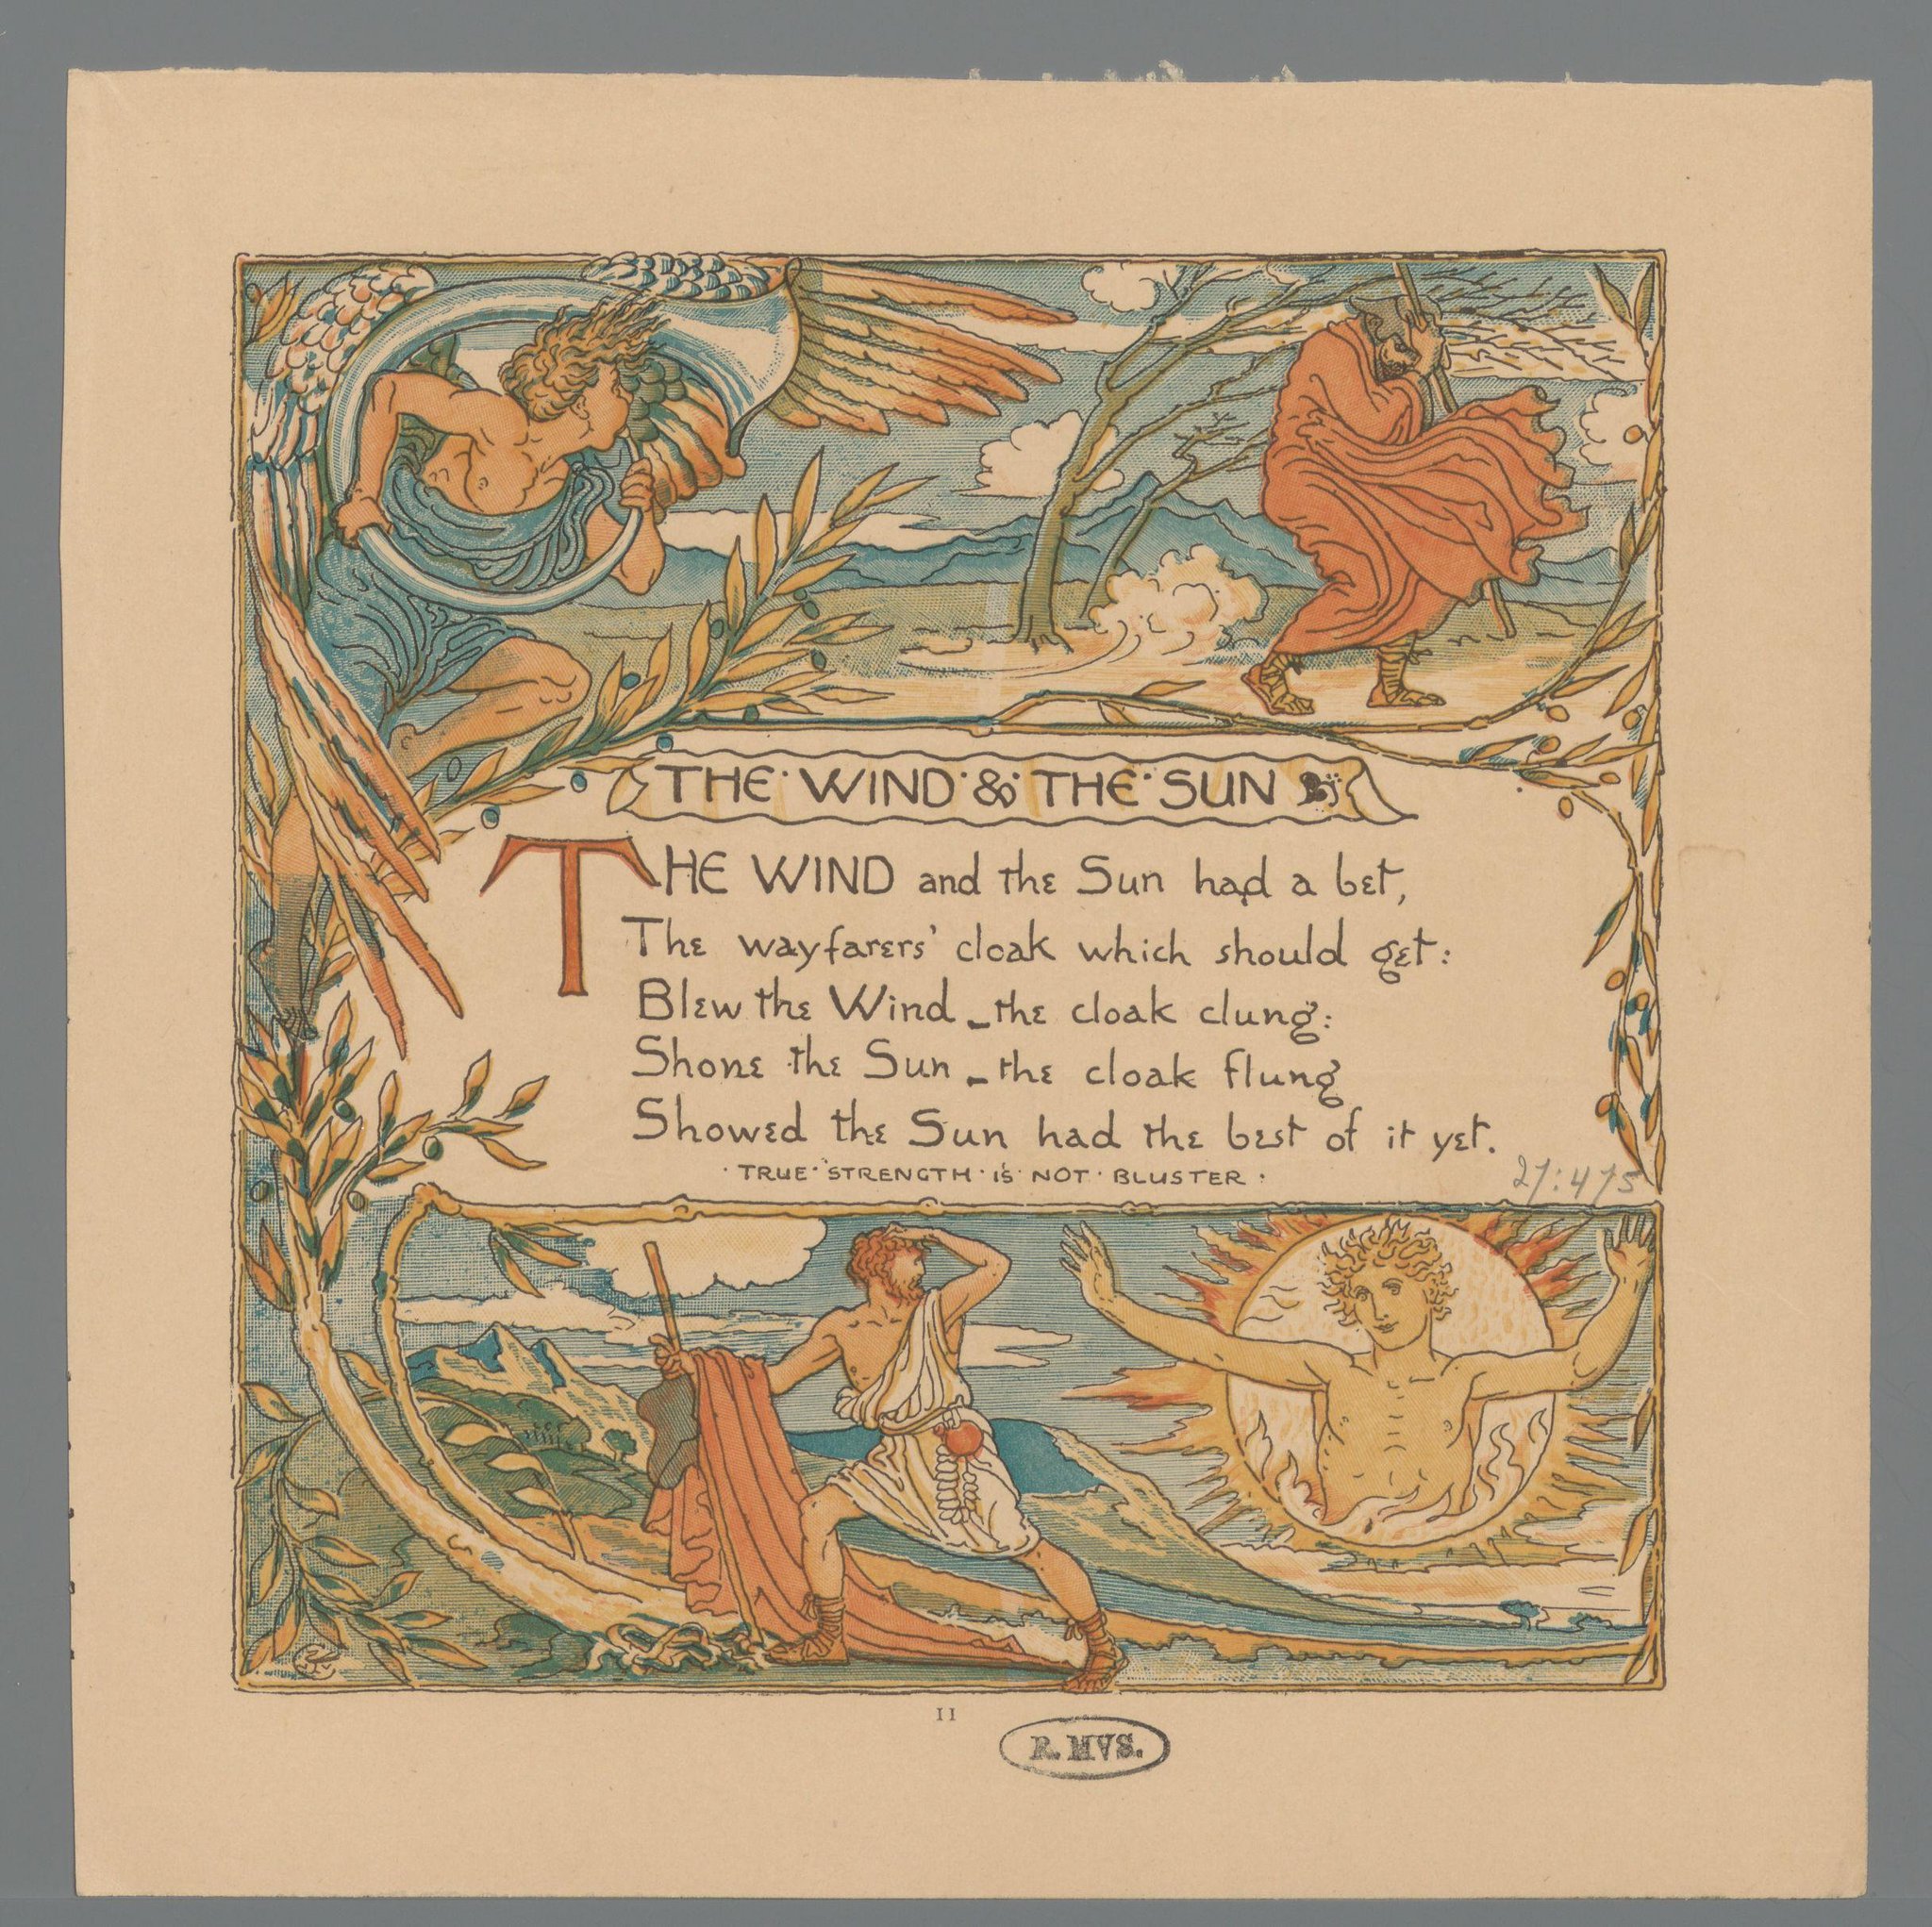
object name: print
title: The wind & the sun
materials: paper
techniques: wood engraving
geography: london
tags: sun represented as face, wheel, etc., winds, 'en route', traveller under way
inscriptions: collector's mark: Lugt 2228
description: Prent uit: The baby's own Aesop being the fables condensed in rhyme. Londen: Routledge & Sons, 1887. Of een latere uitgave.